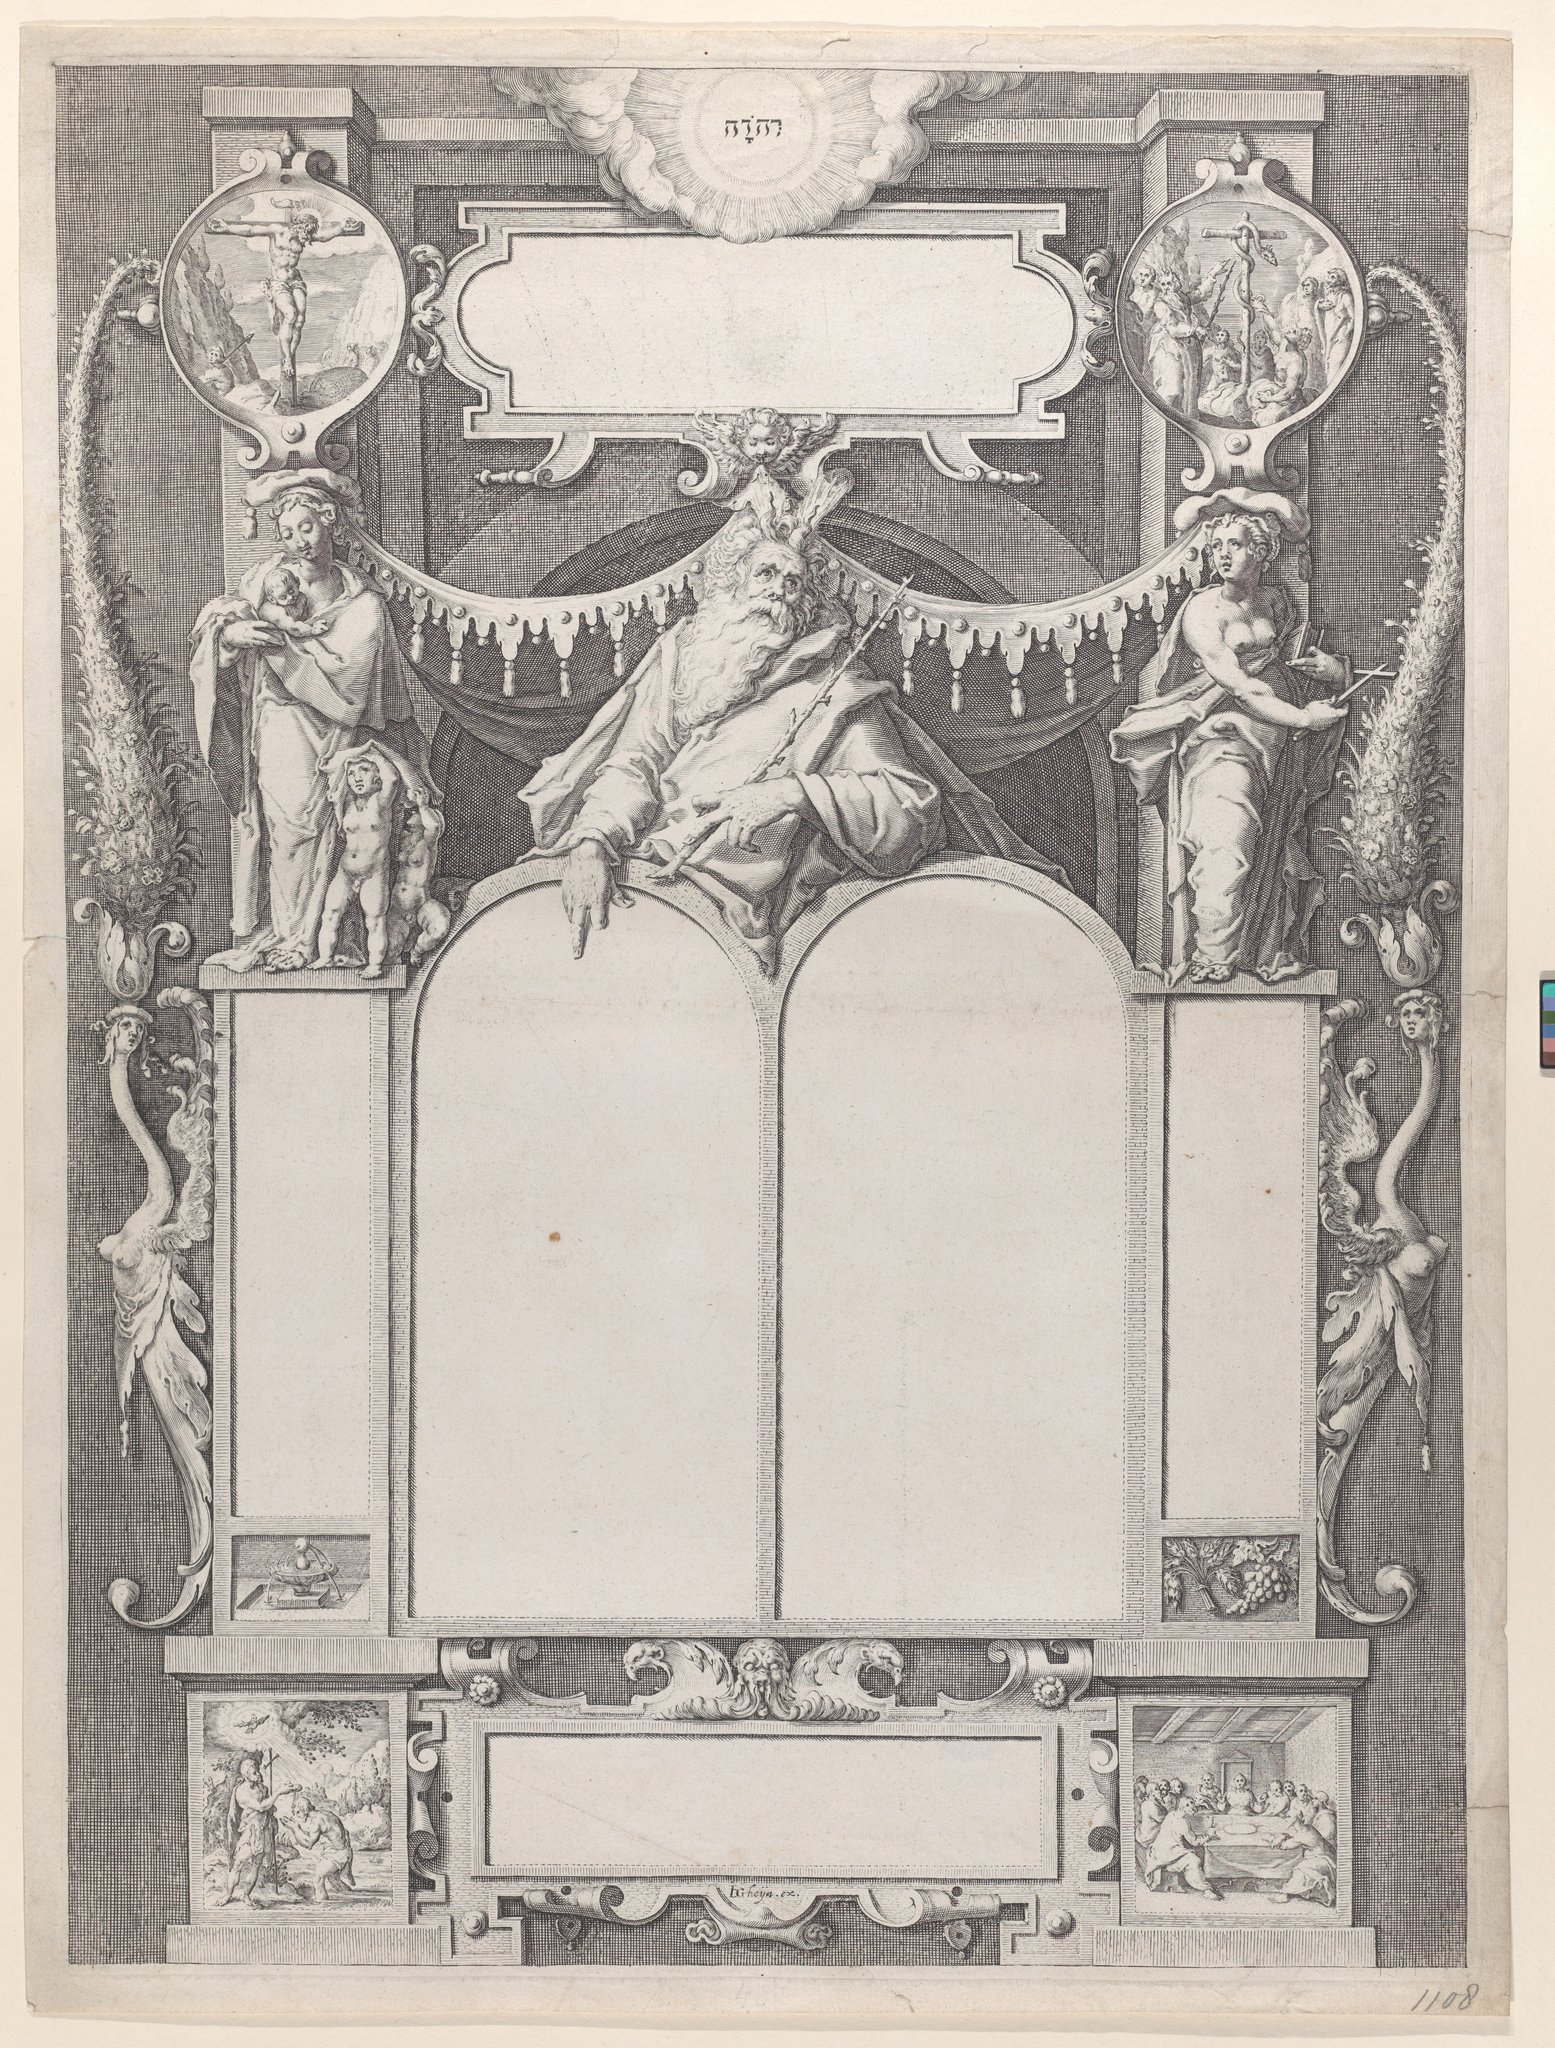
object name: print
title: Moses with the Tables of the Law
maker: jacques de gheyn (ii)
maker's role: artist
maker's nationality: netherlandish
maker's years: 1565-1629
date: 1590-1600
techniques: engraving